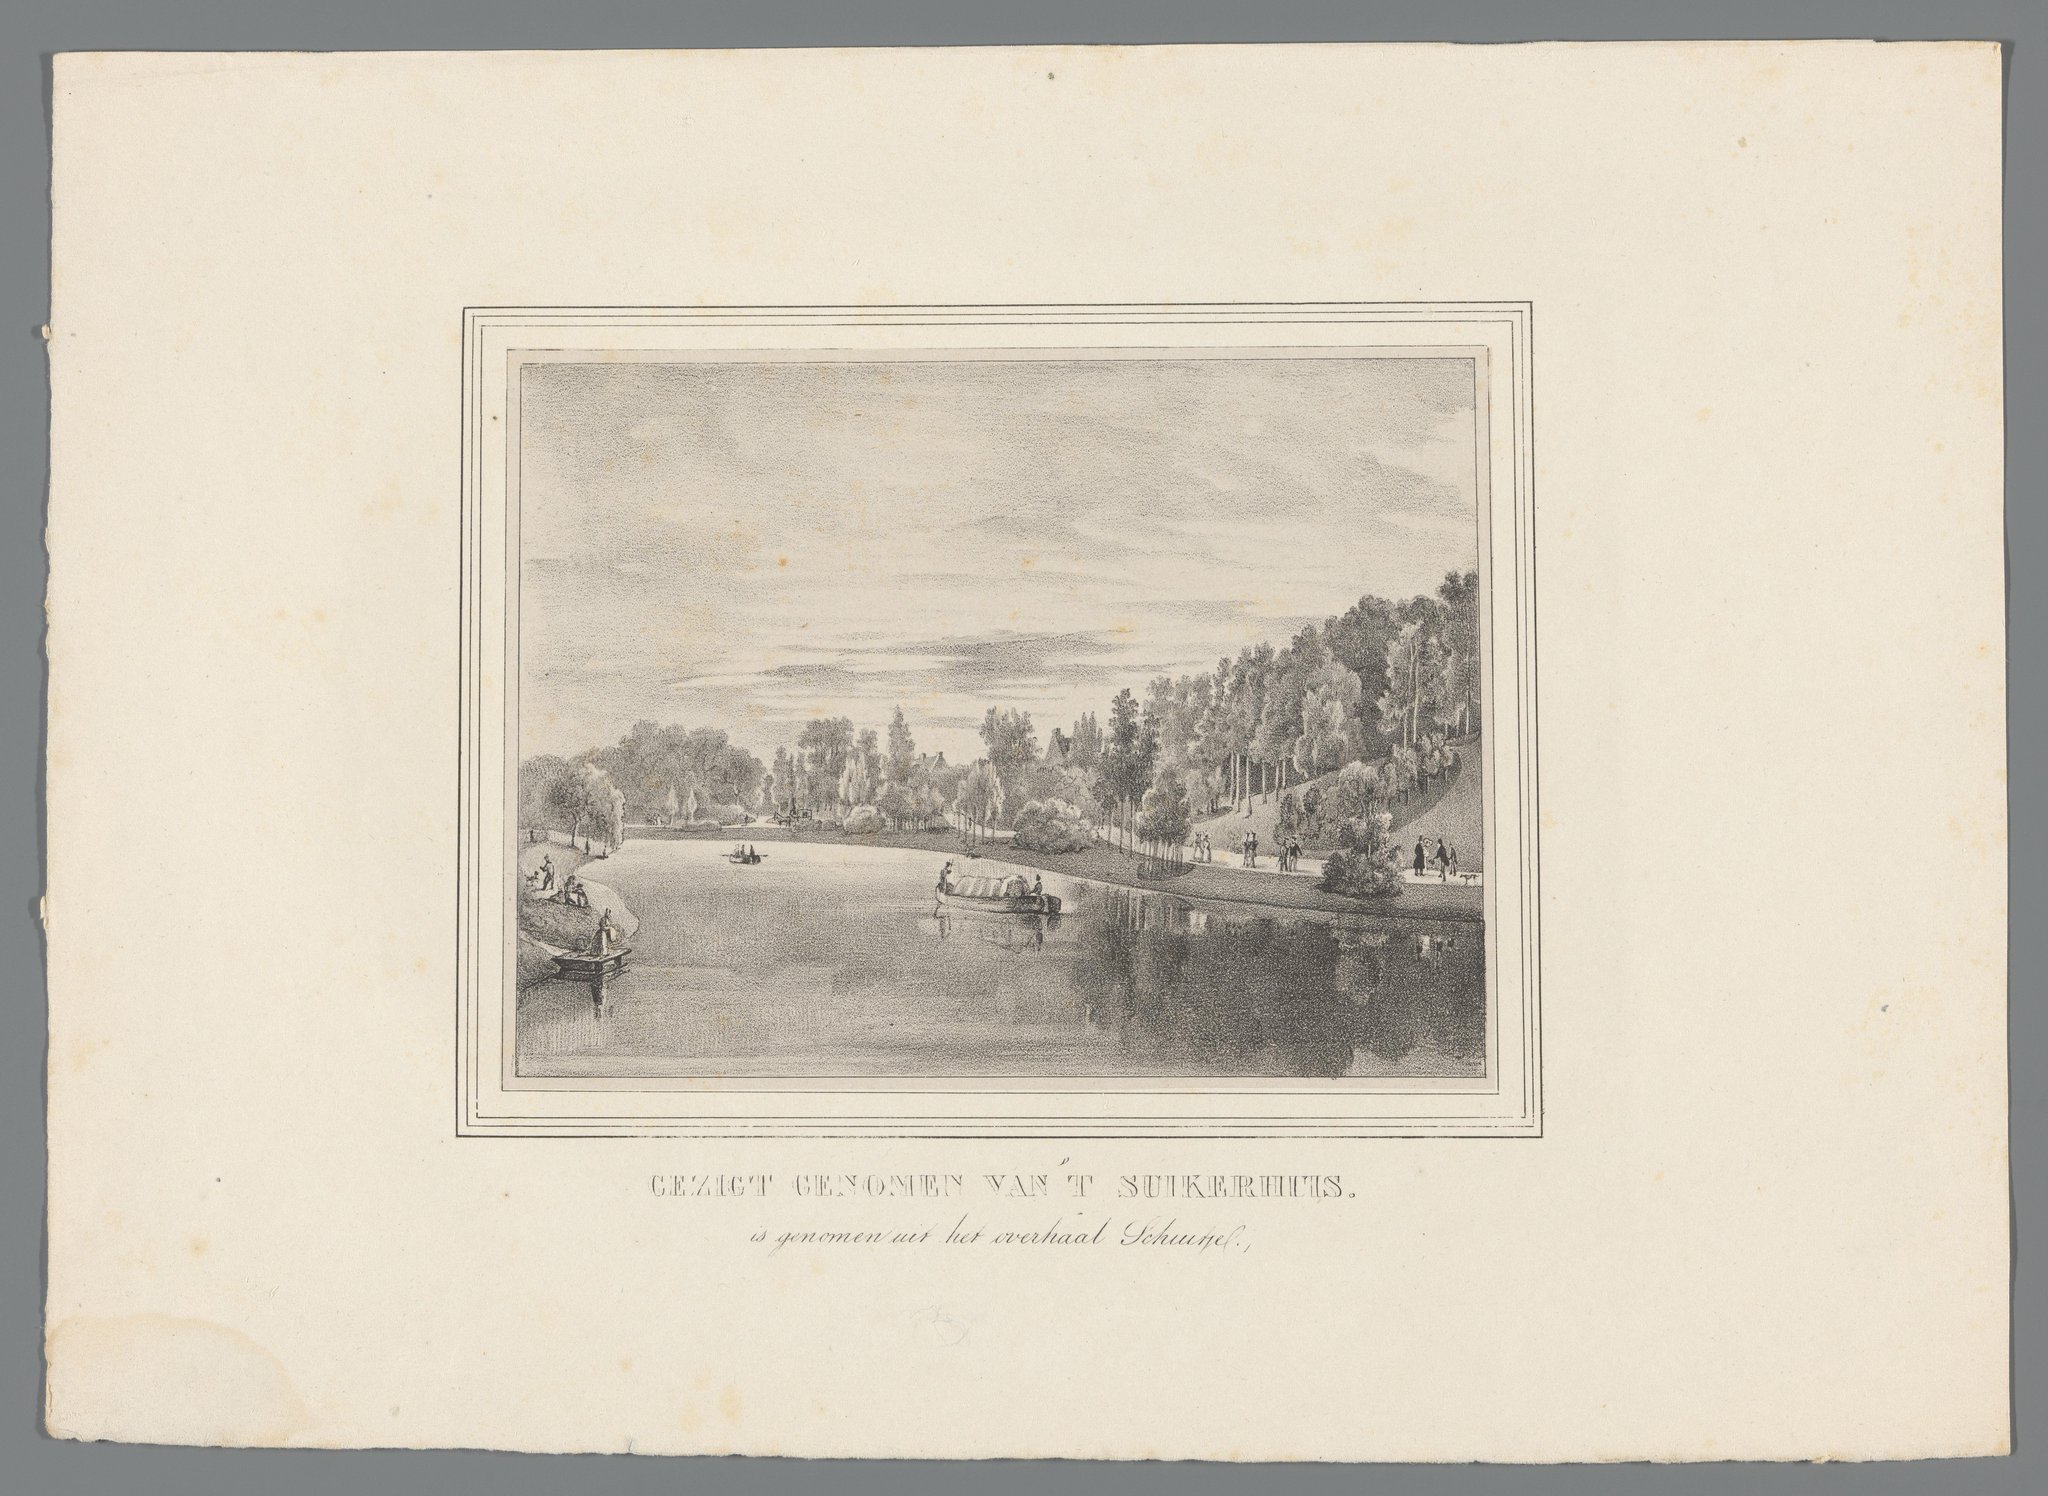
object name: print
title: Gezigt genomen van 't Suikerhuis / is genomen uit het overhaal Schuytje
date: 1831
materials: ink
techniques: lithograph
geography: utrecht